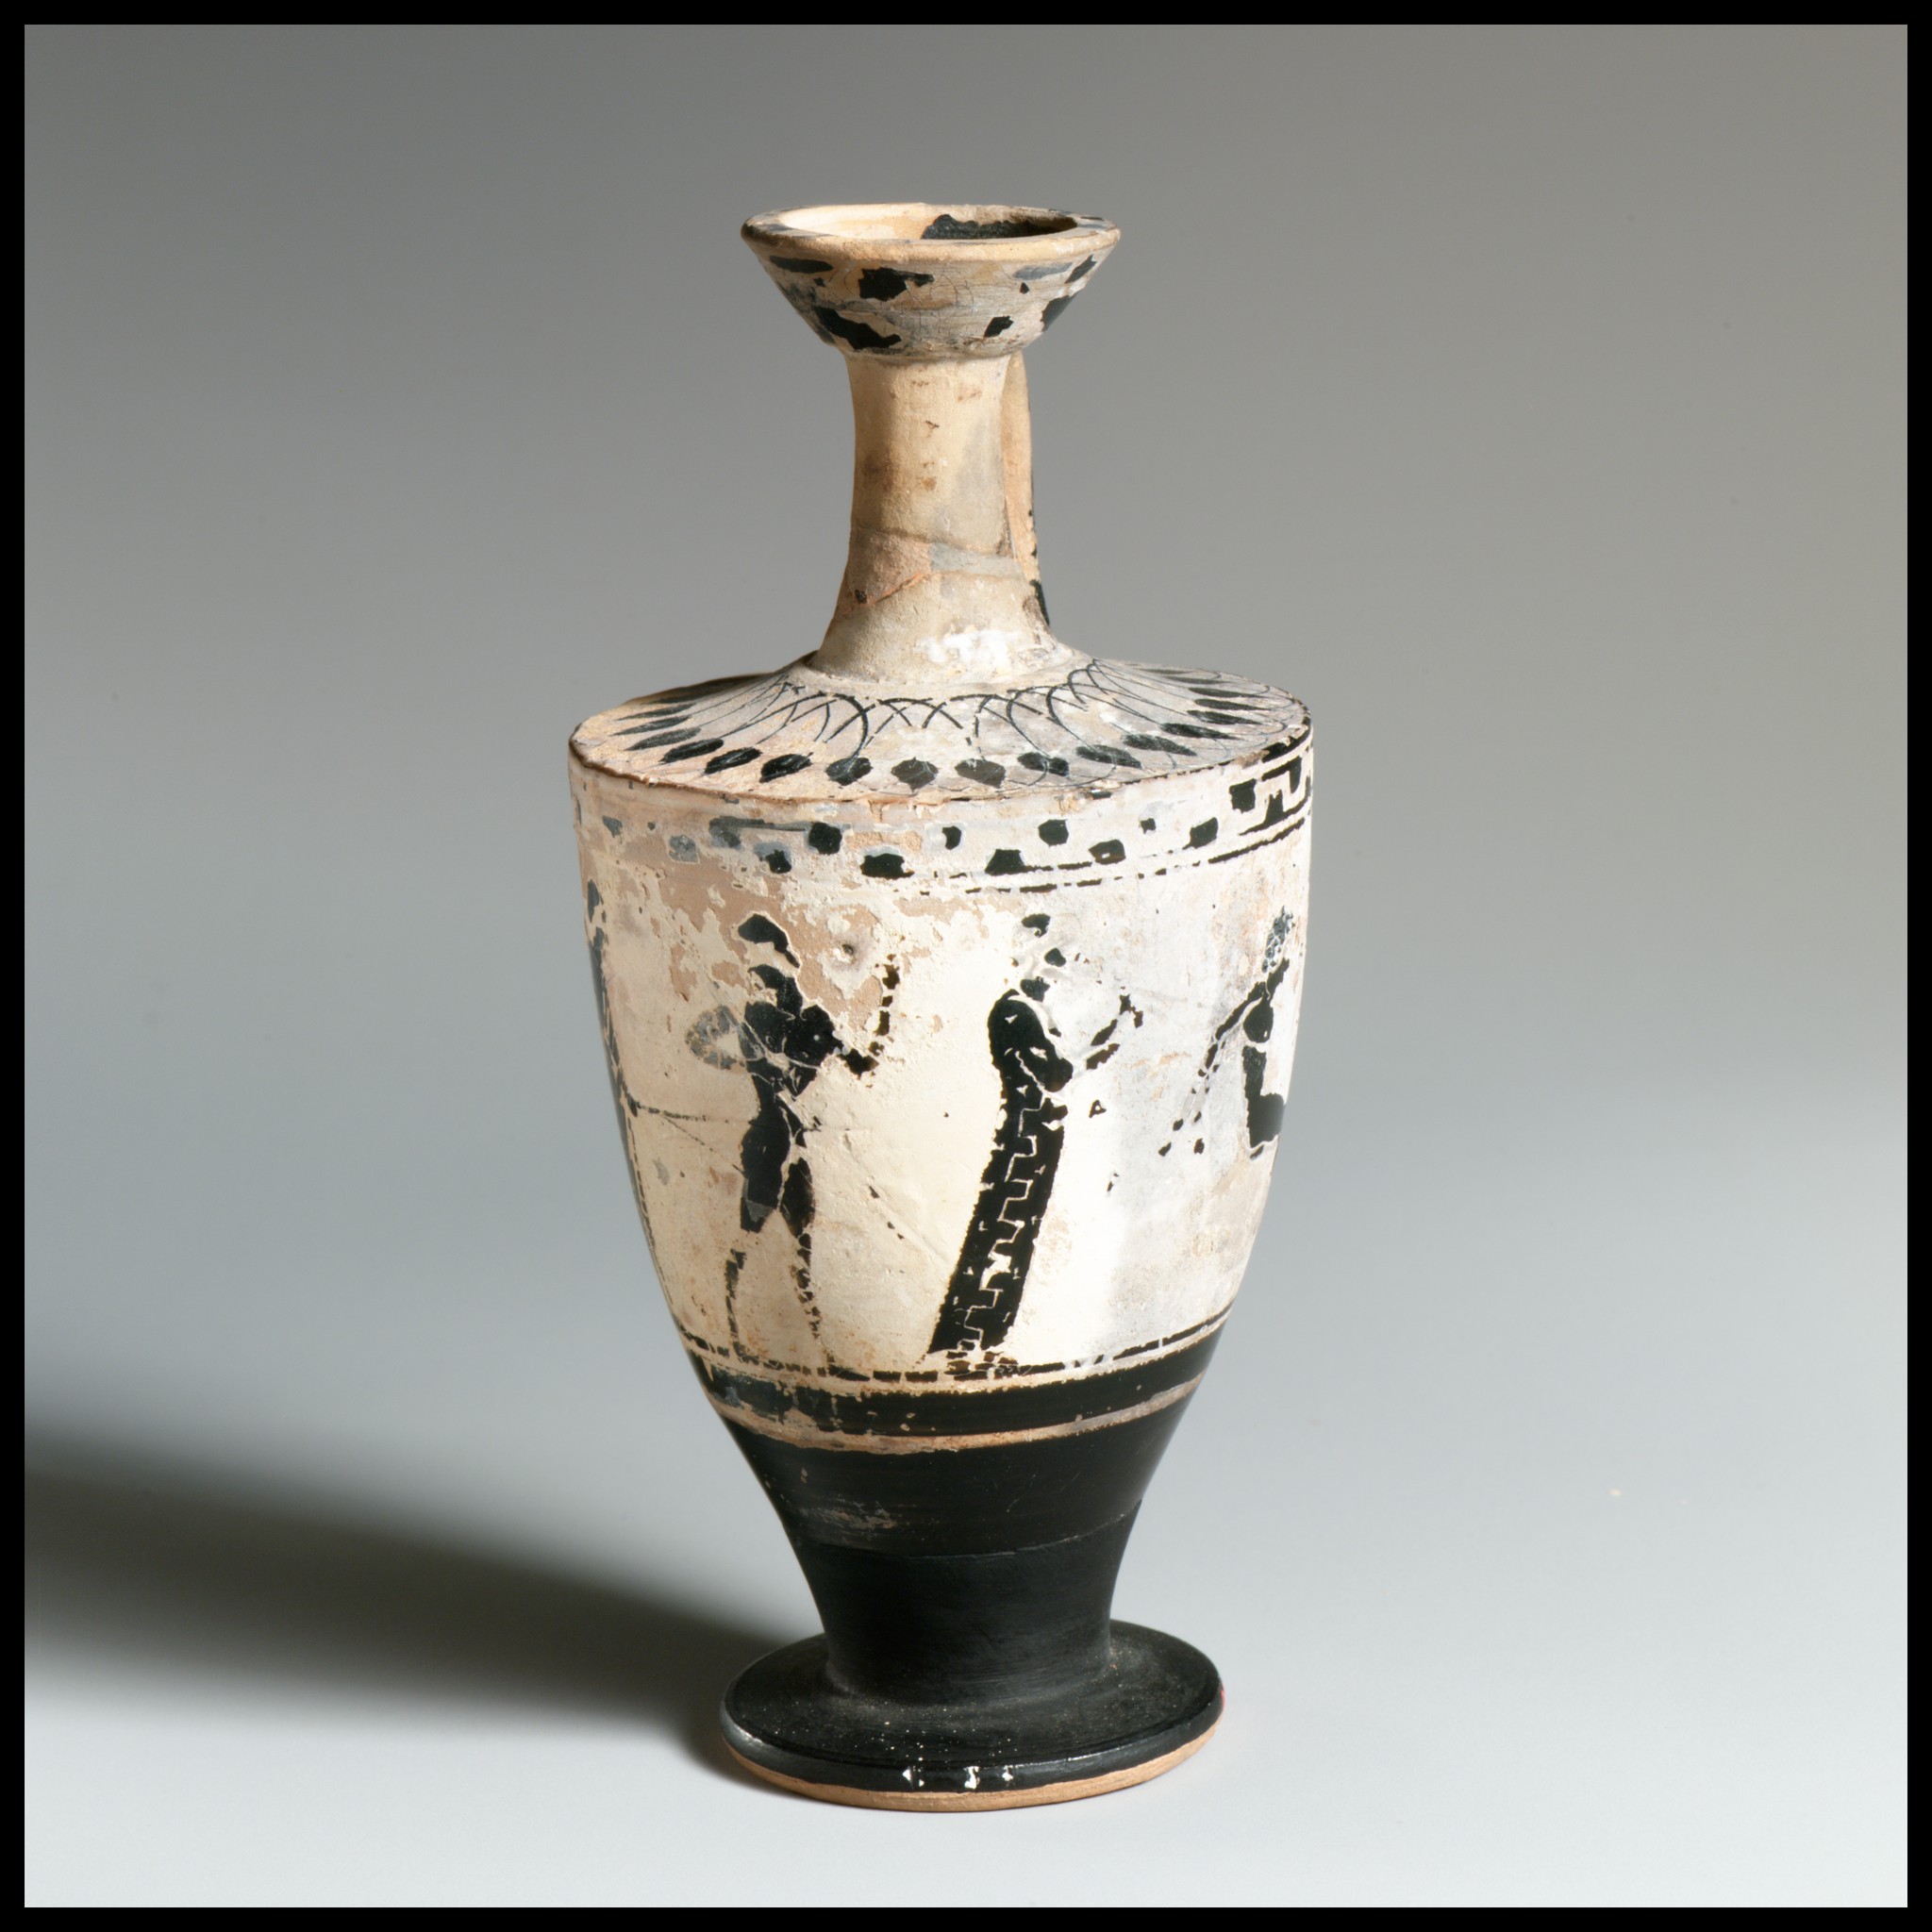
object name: lekythos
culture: greek, attic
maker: kephisophon painter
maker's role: artist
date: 500-490 BCE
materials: terracotta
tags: human figures